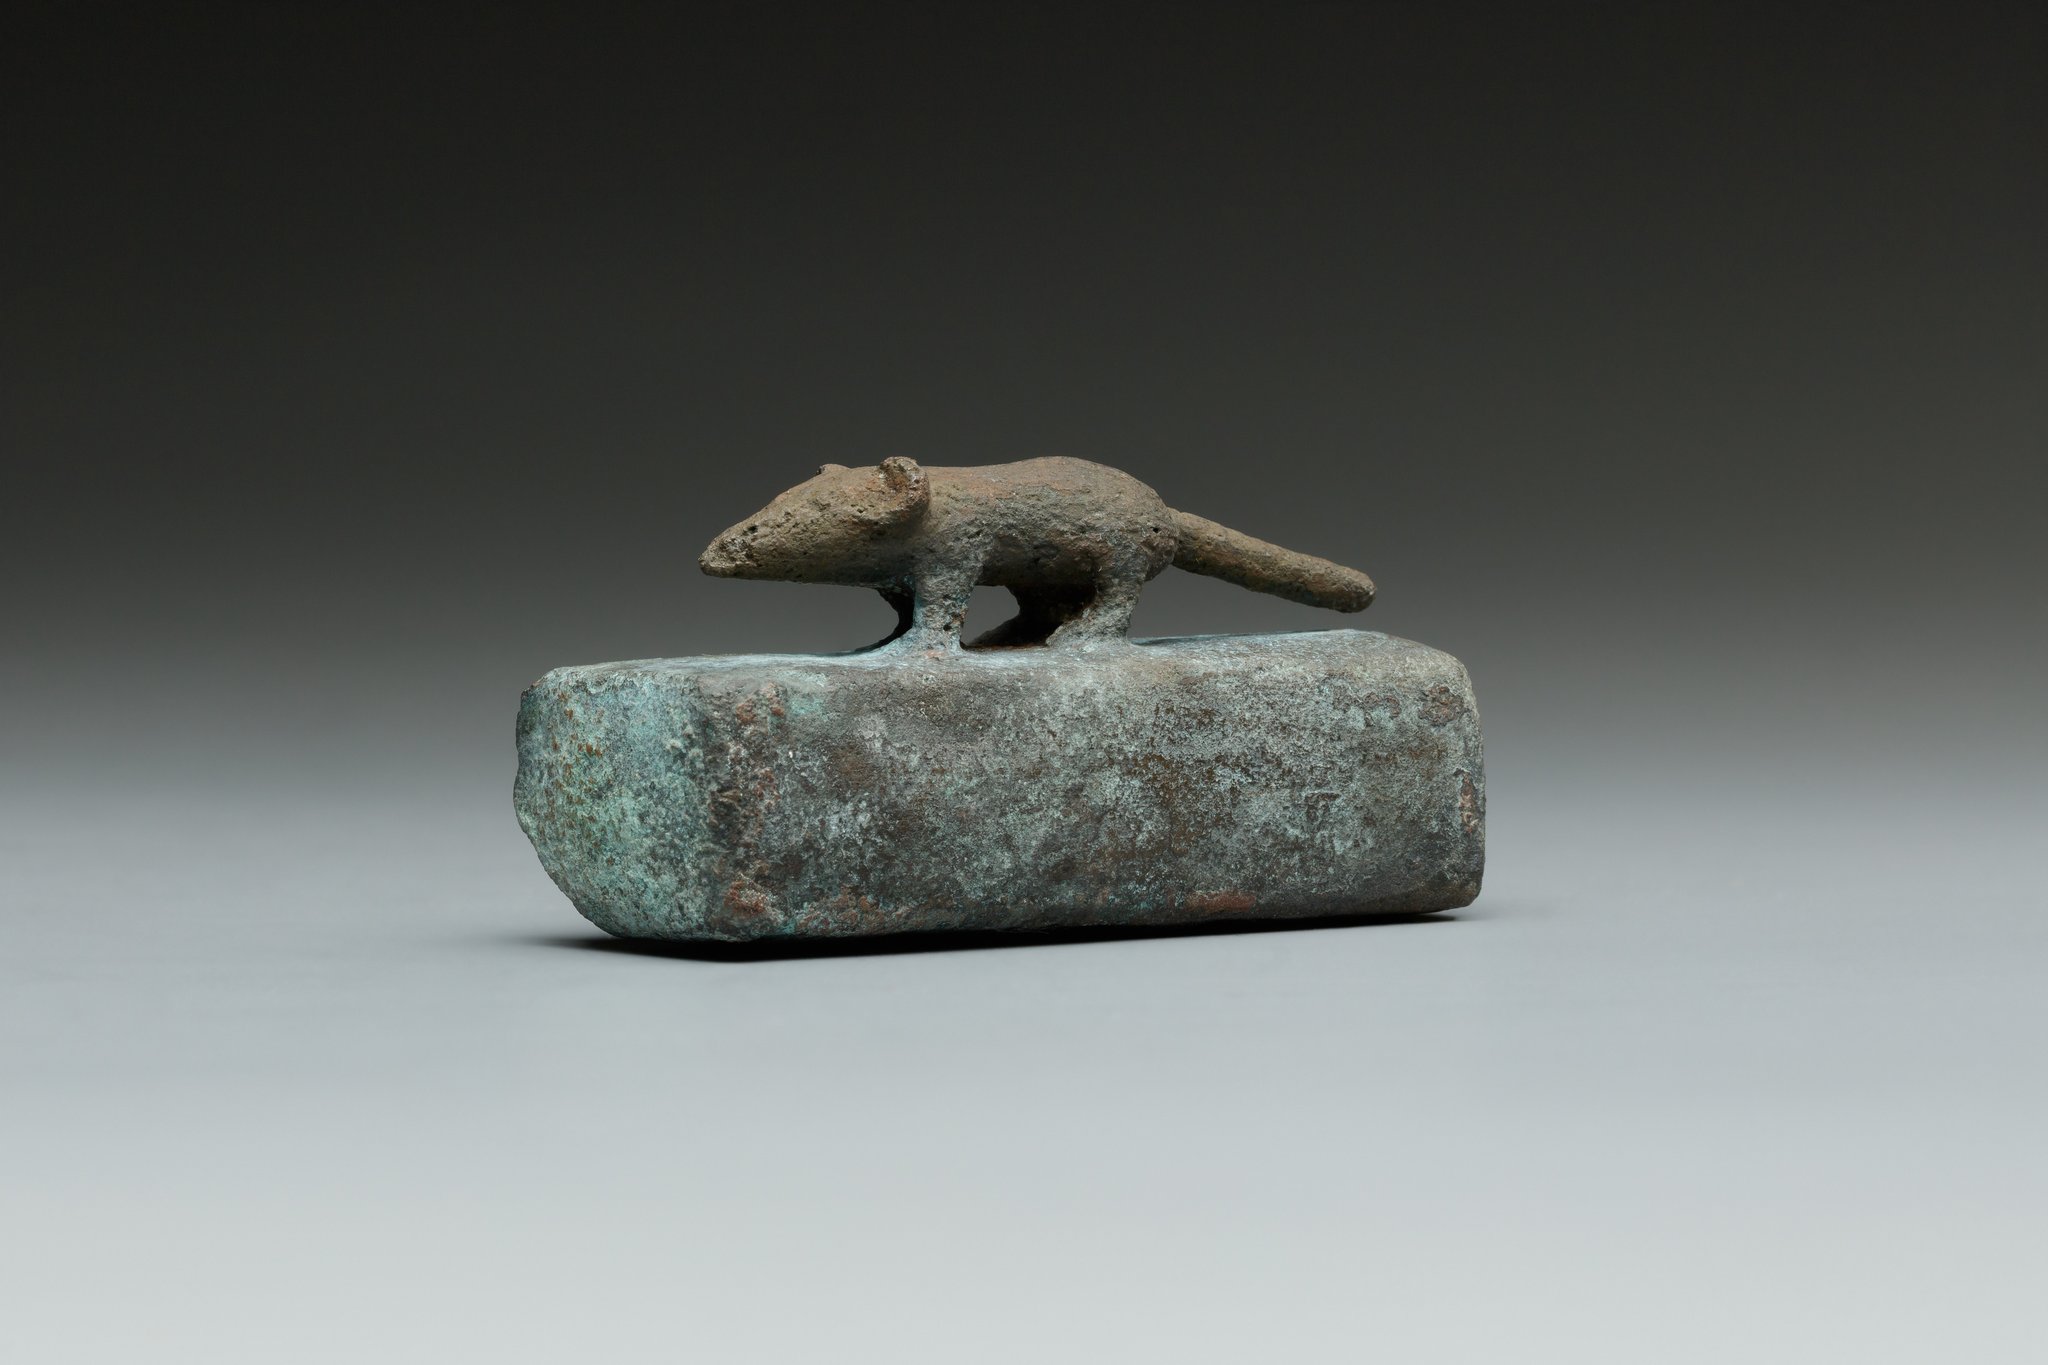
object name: box, mouse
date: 688-525 BCE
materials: bronze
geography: egypt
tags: mice